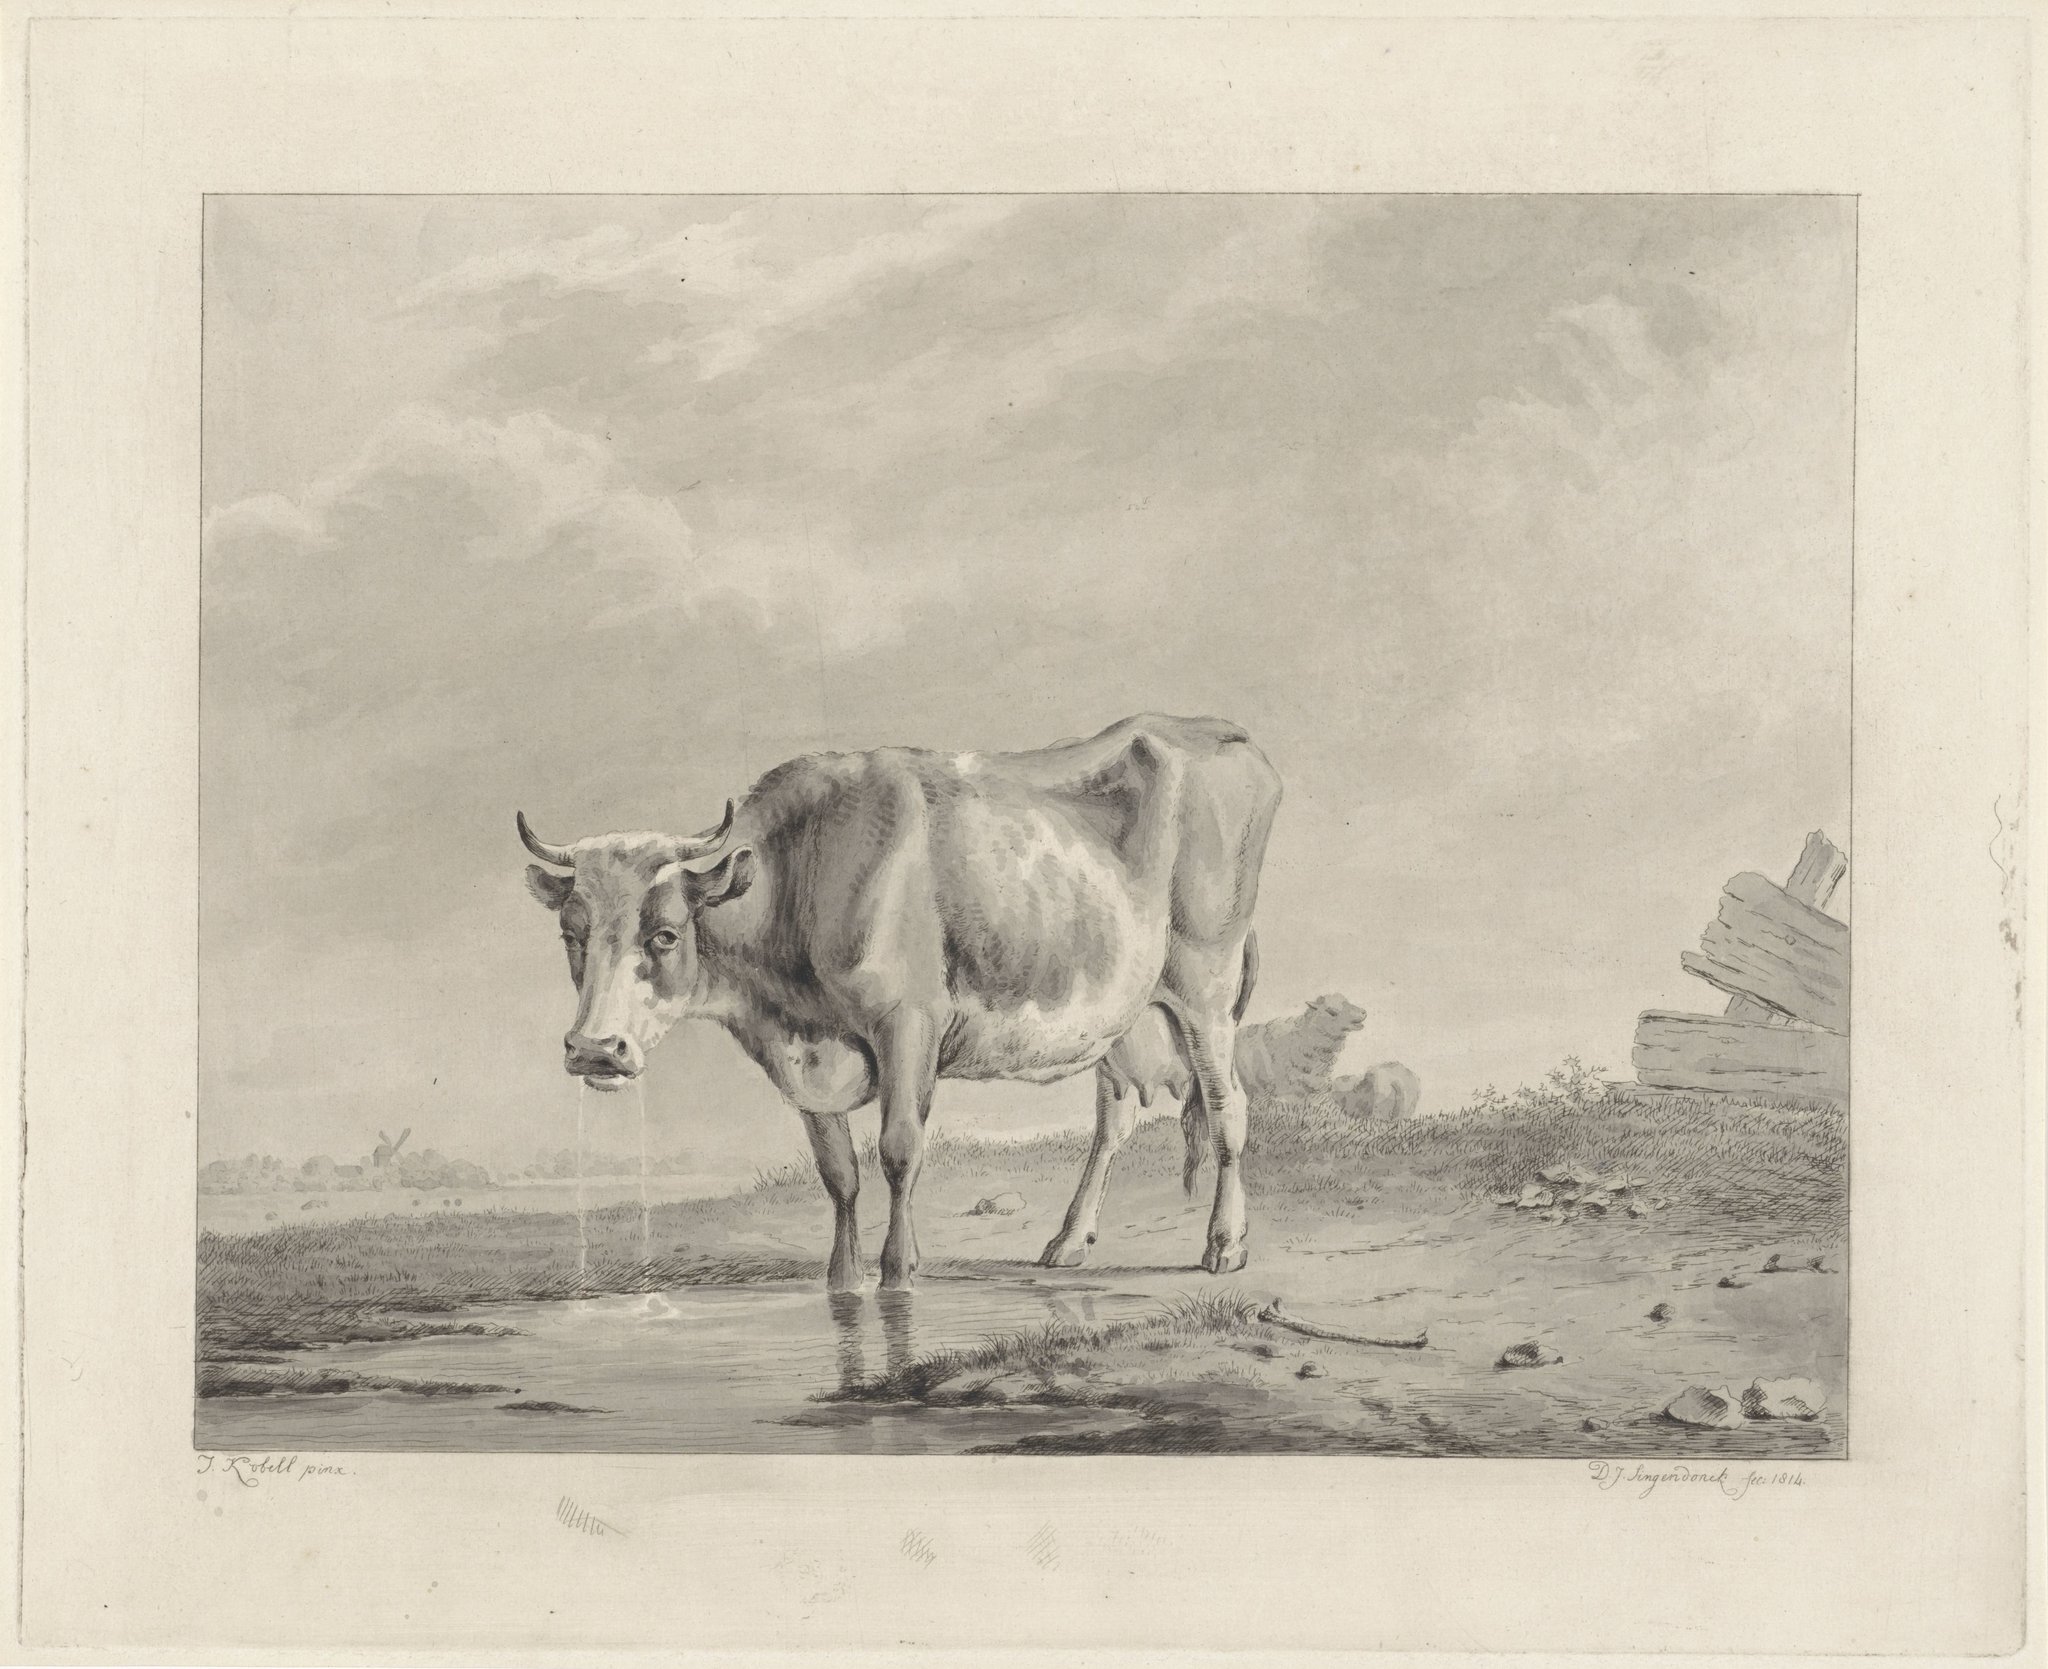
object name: print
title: Drinkende koe aan het water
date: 1814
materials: paper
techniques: brush, etching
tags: cow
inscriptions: collector's mark: Lugt 2228